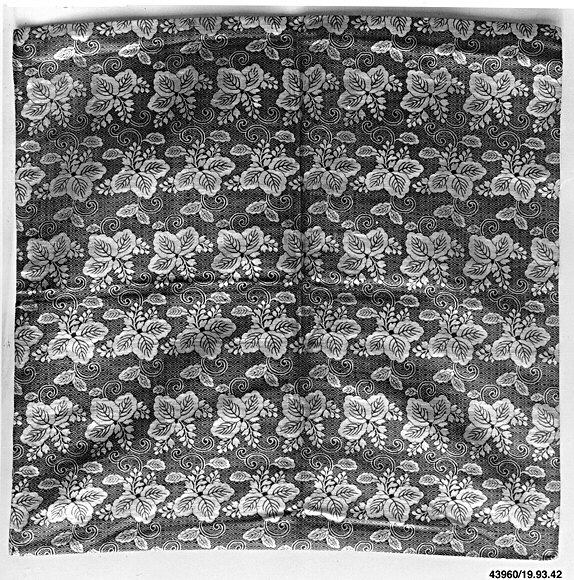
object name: altar cloth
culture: japanese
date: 1834-1866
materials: metal thread, silk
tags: leaves